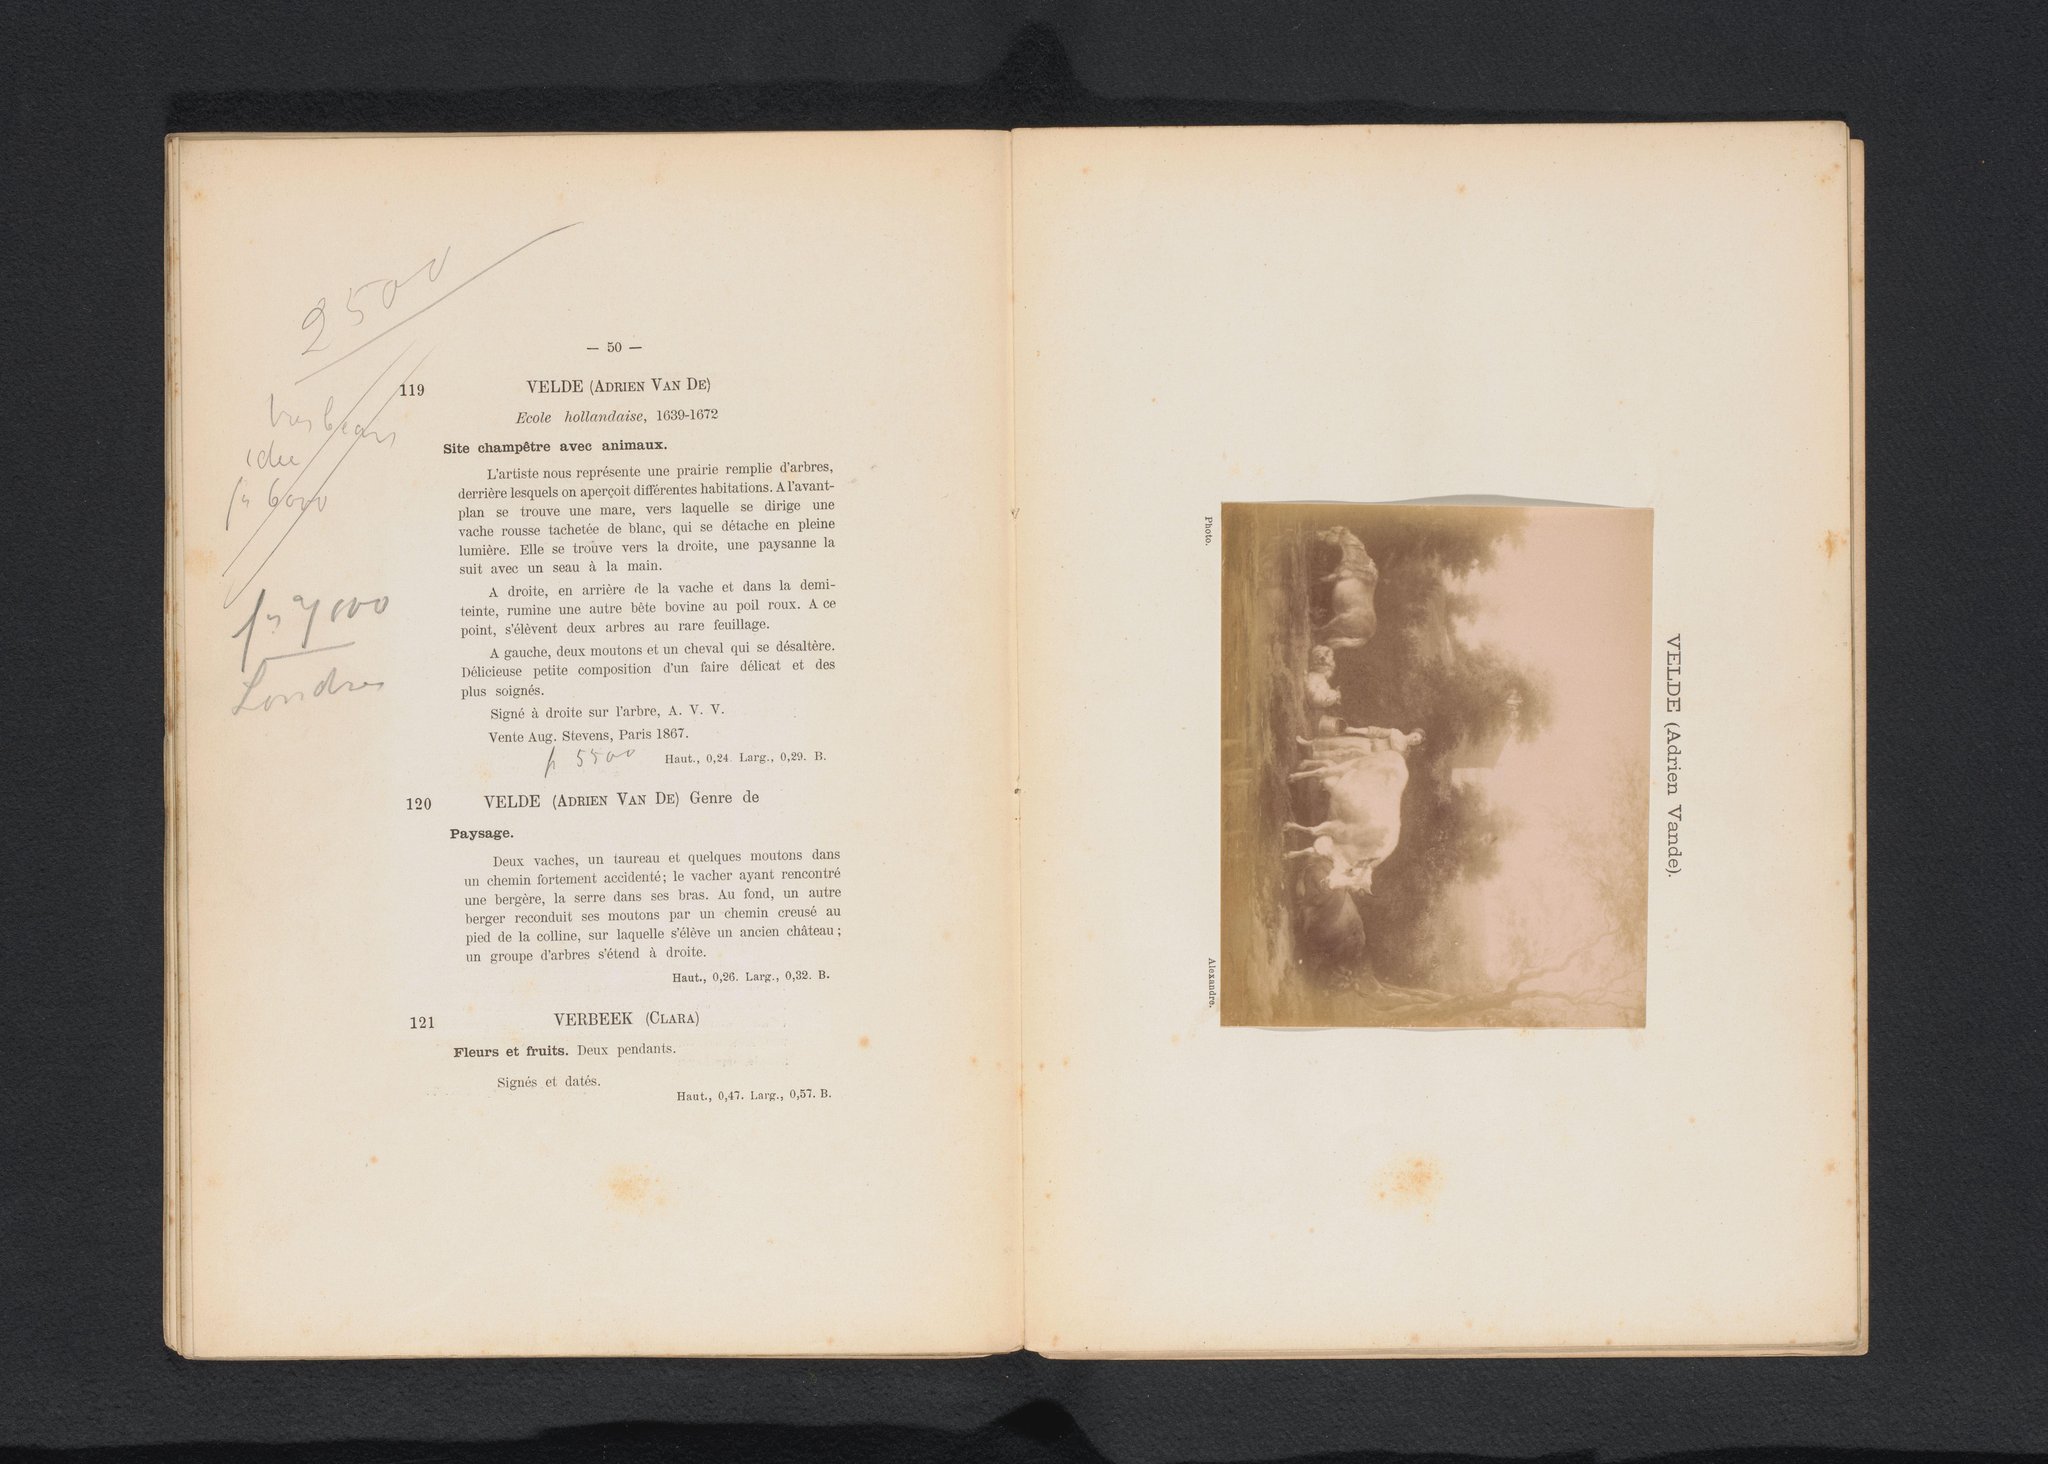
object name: photograph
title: Fotoreproductie van een schilderij van een vrouw en een kudde koeien en schapen, door Adriaen van de Velde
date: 1886-1891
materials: photographic support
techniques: albumen print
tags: cow, adult woman, sheep